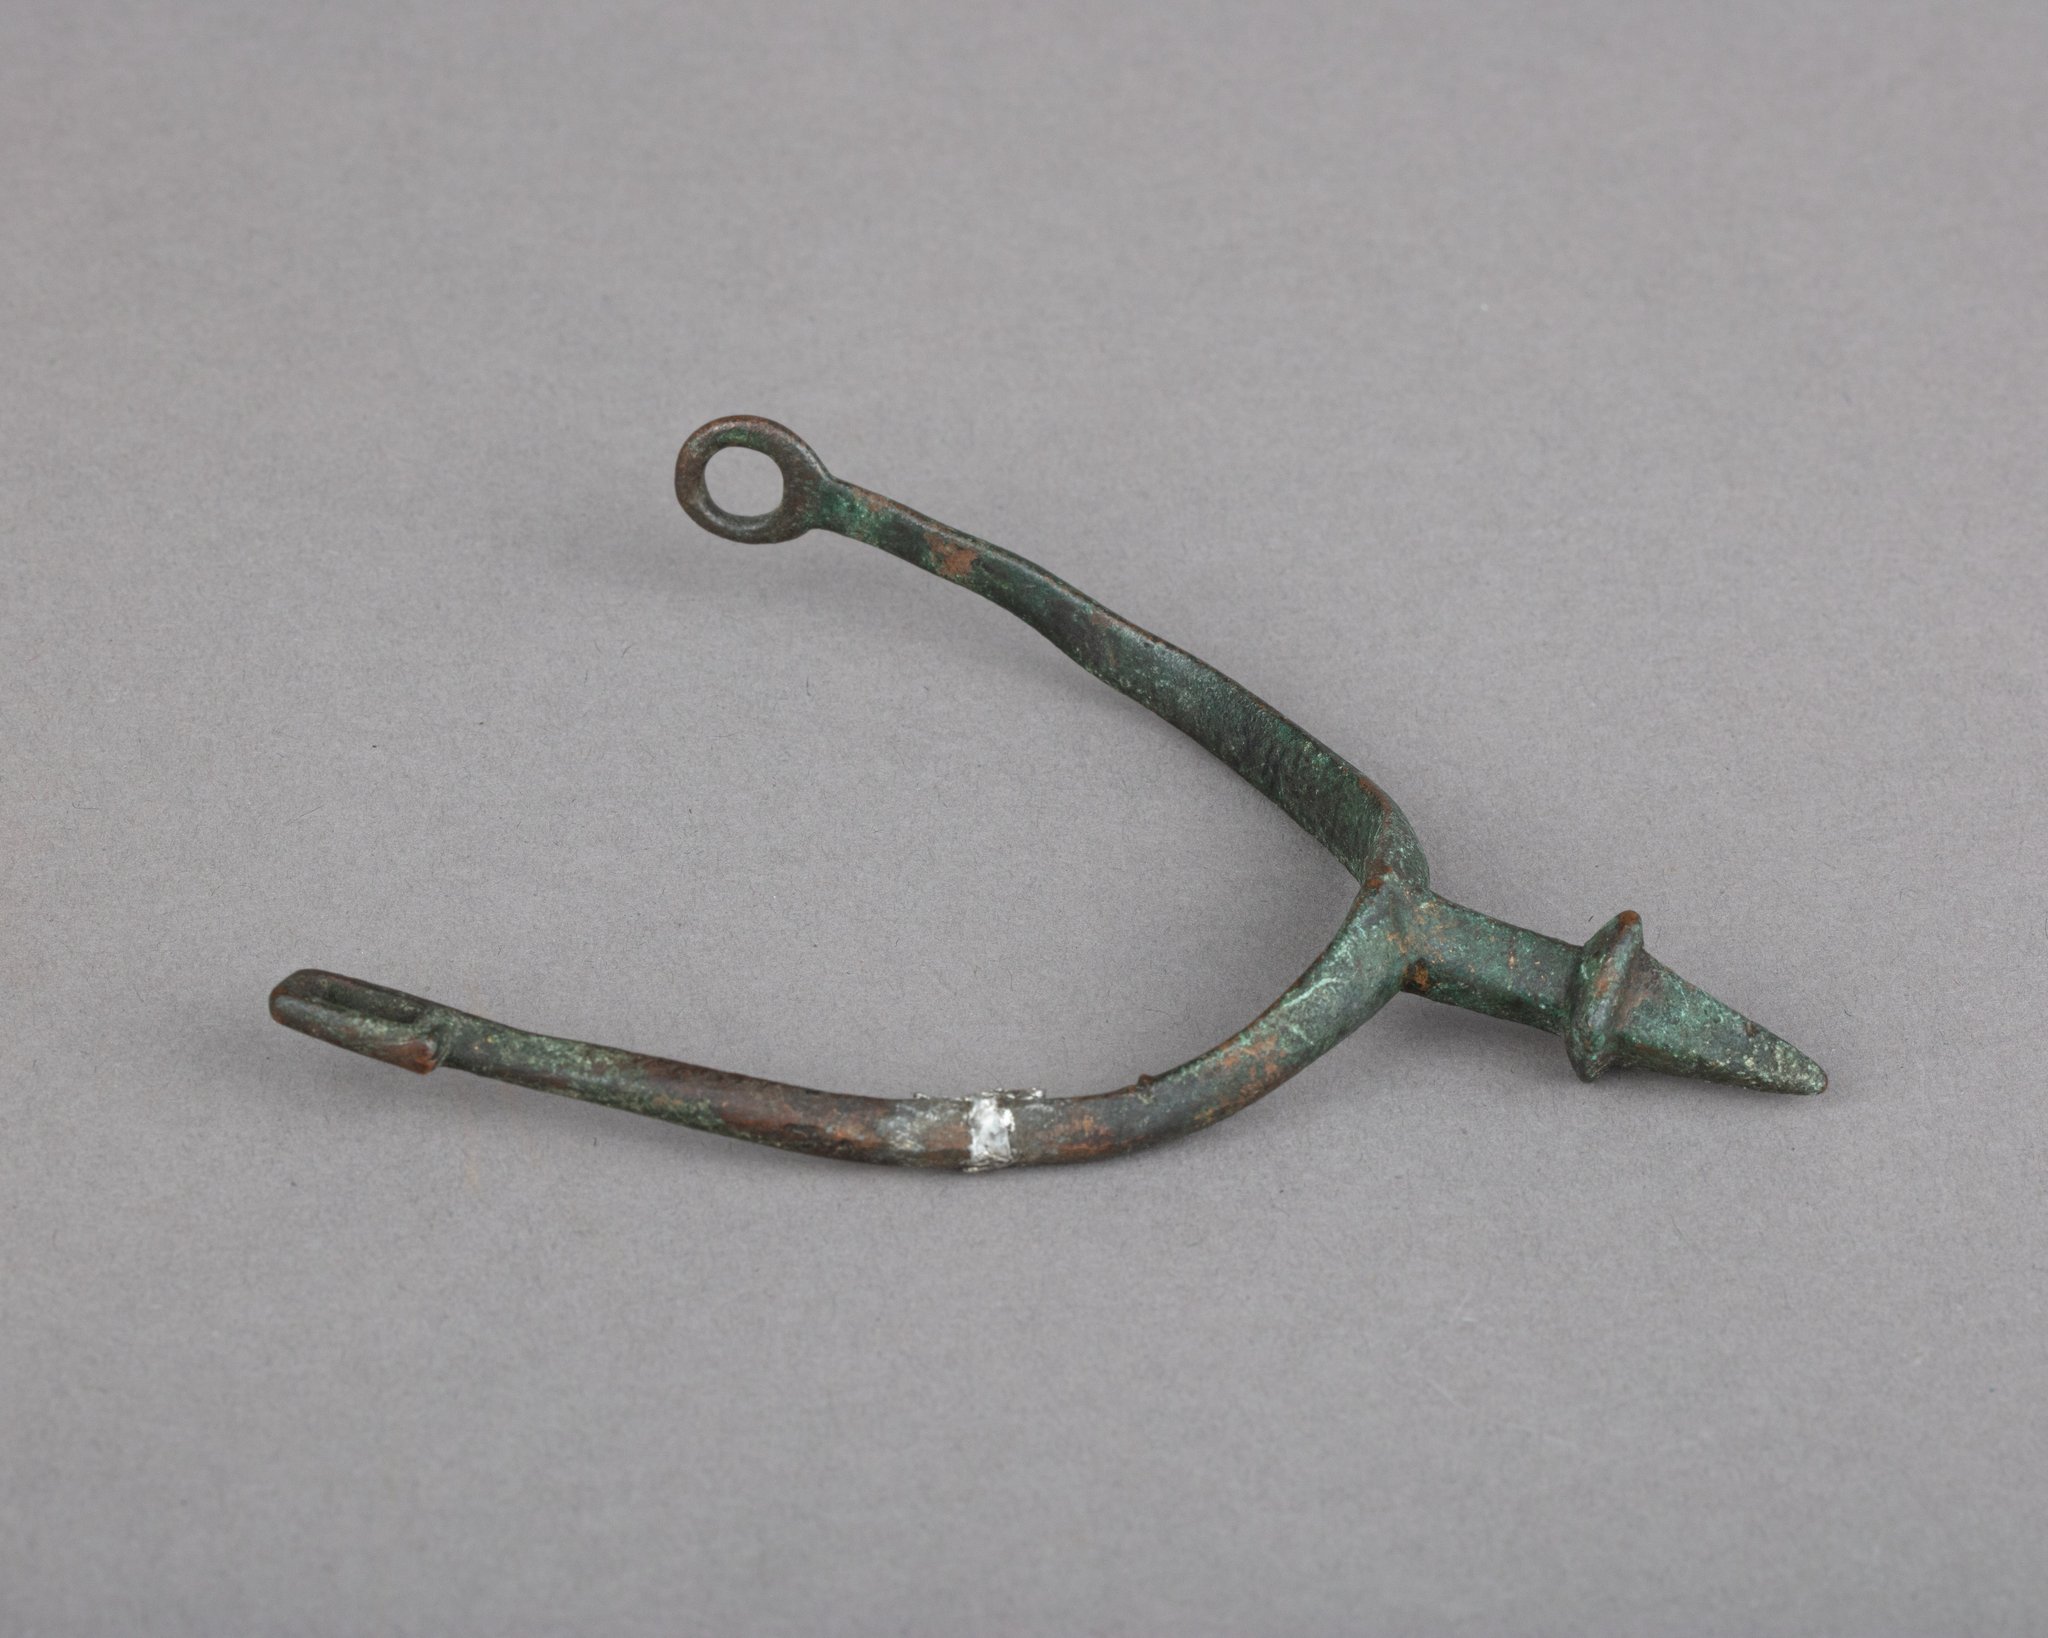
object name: spur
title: Prick Spur (Right)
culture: german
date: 1201-1300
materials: copper alloy, gold, tin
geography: germany